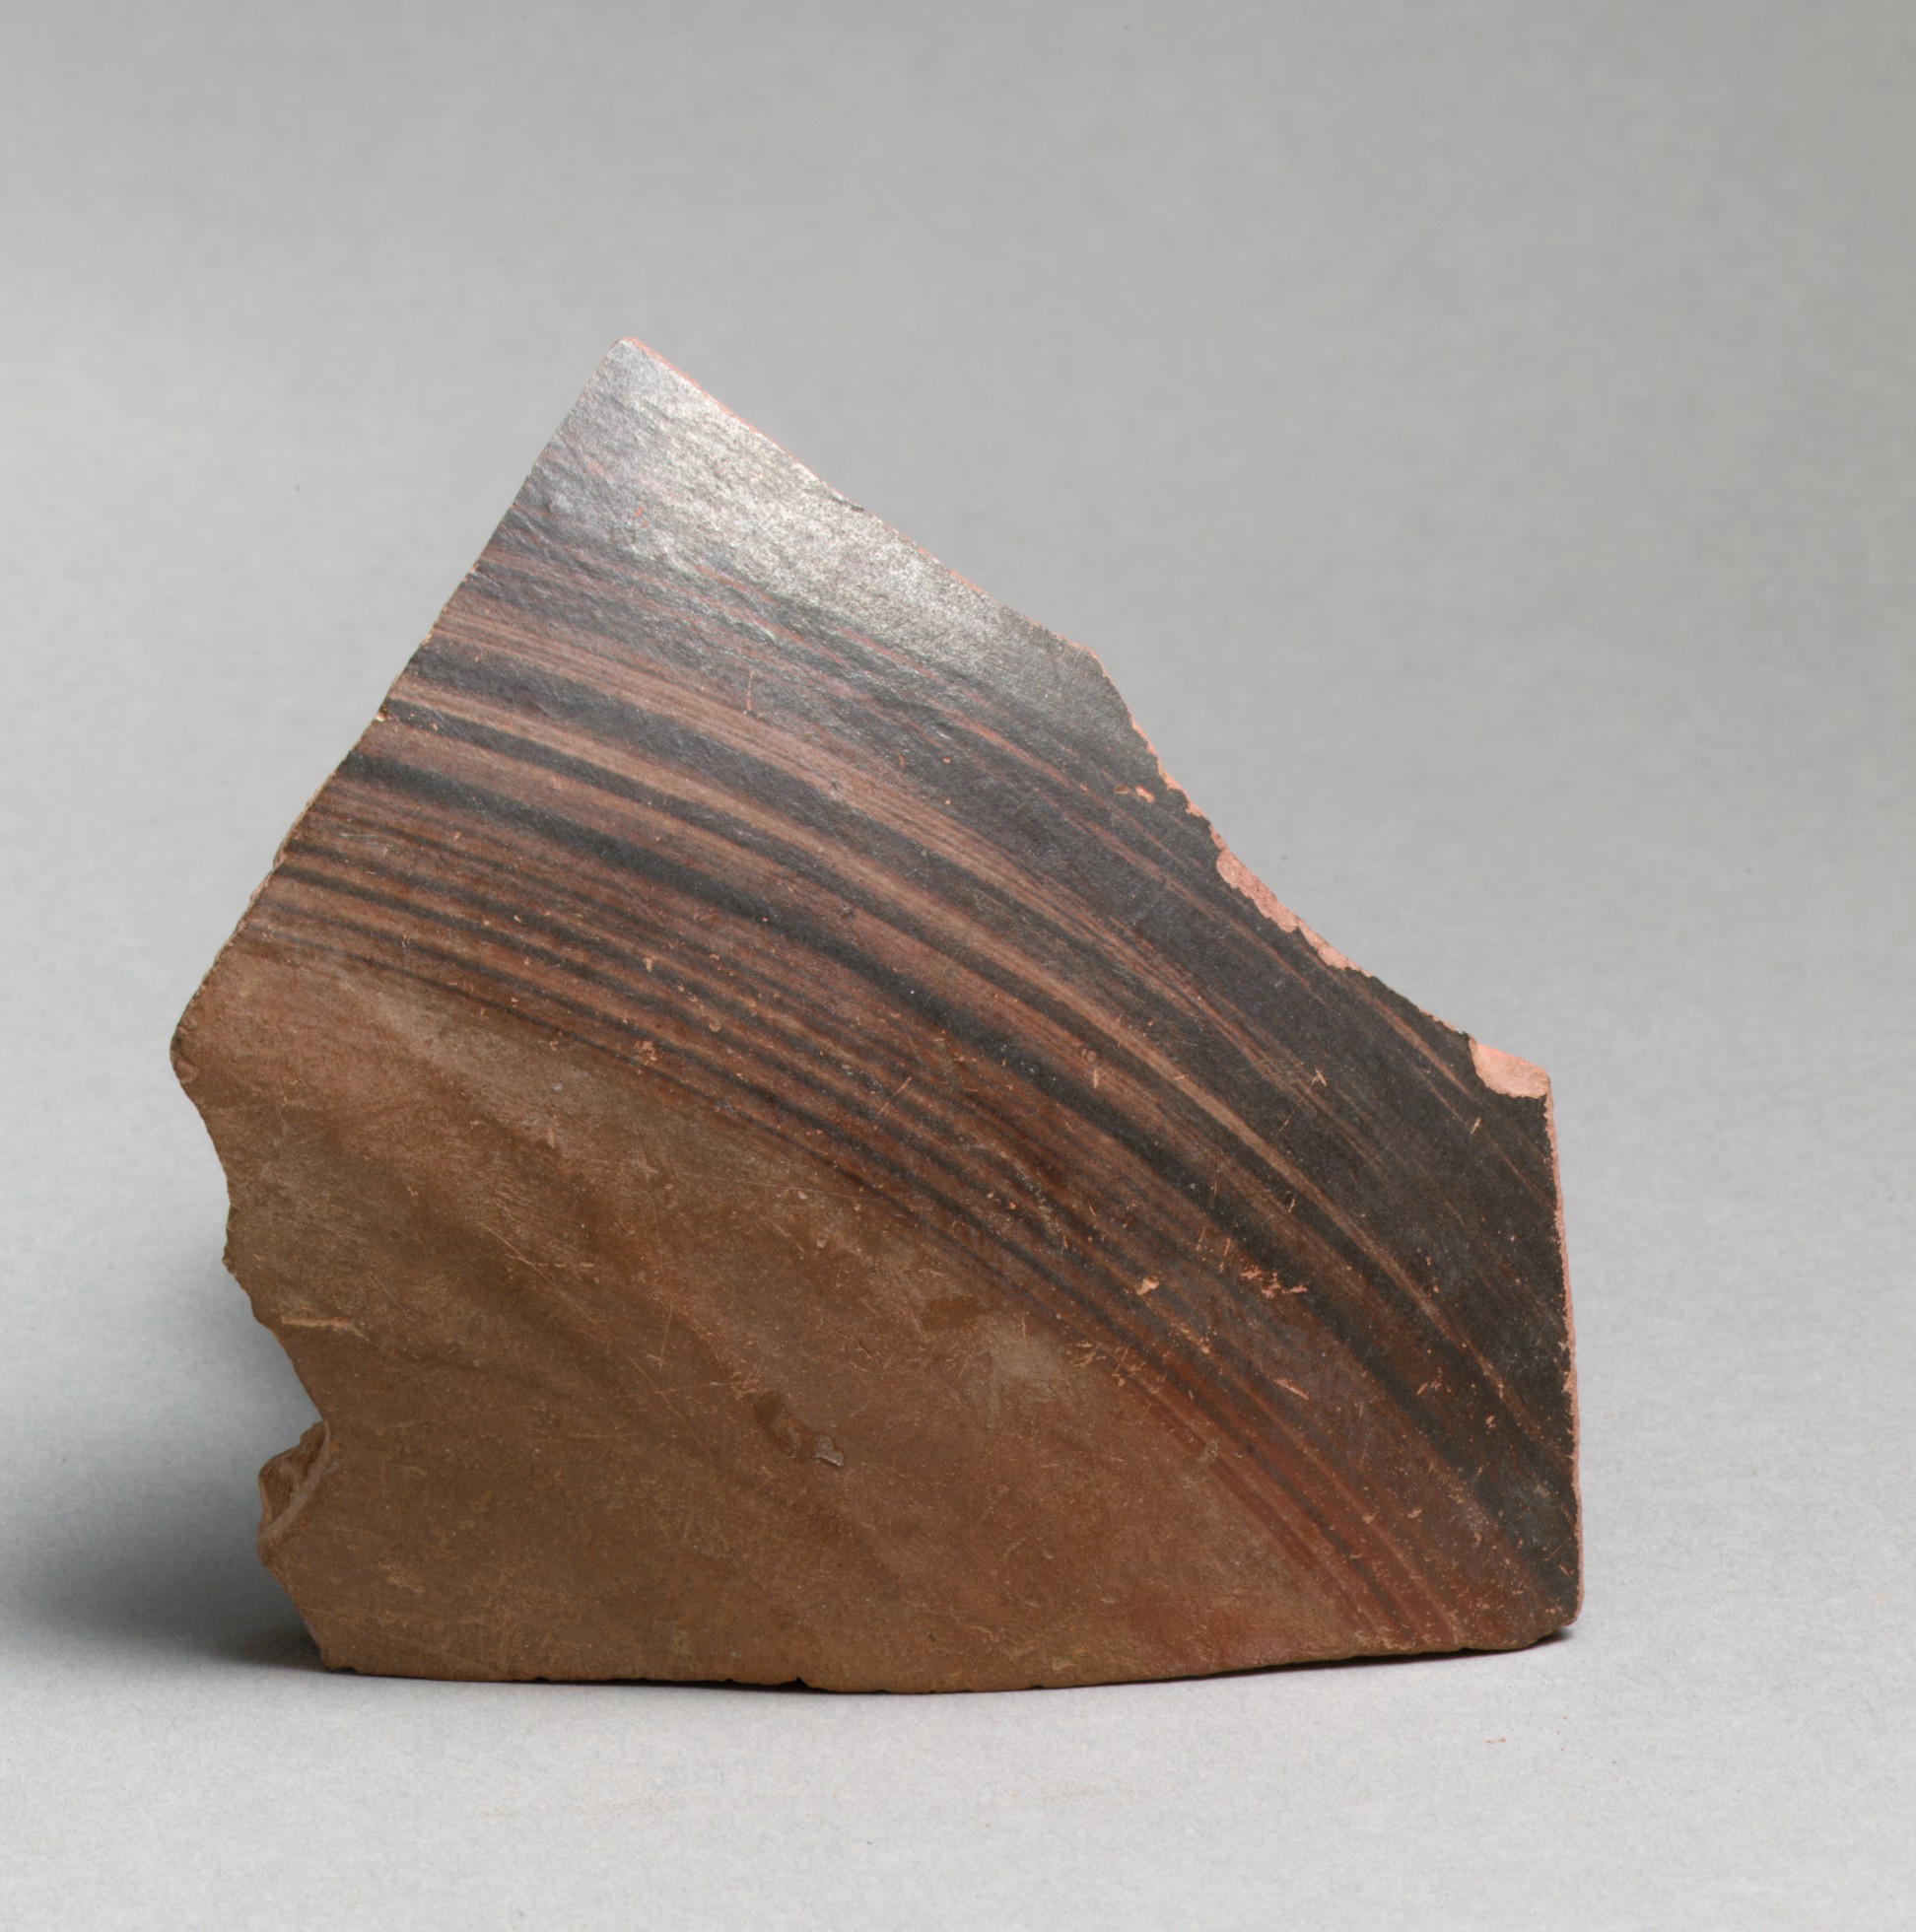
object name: vase fragment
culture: greek or lydian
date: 900-30 BCE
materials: terracotta